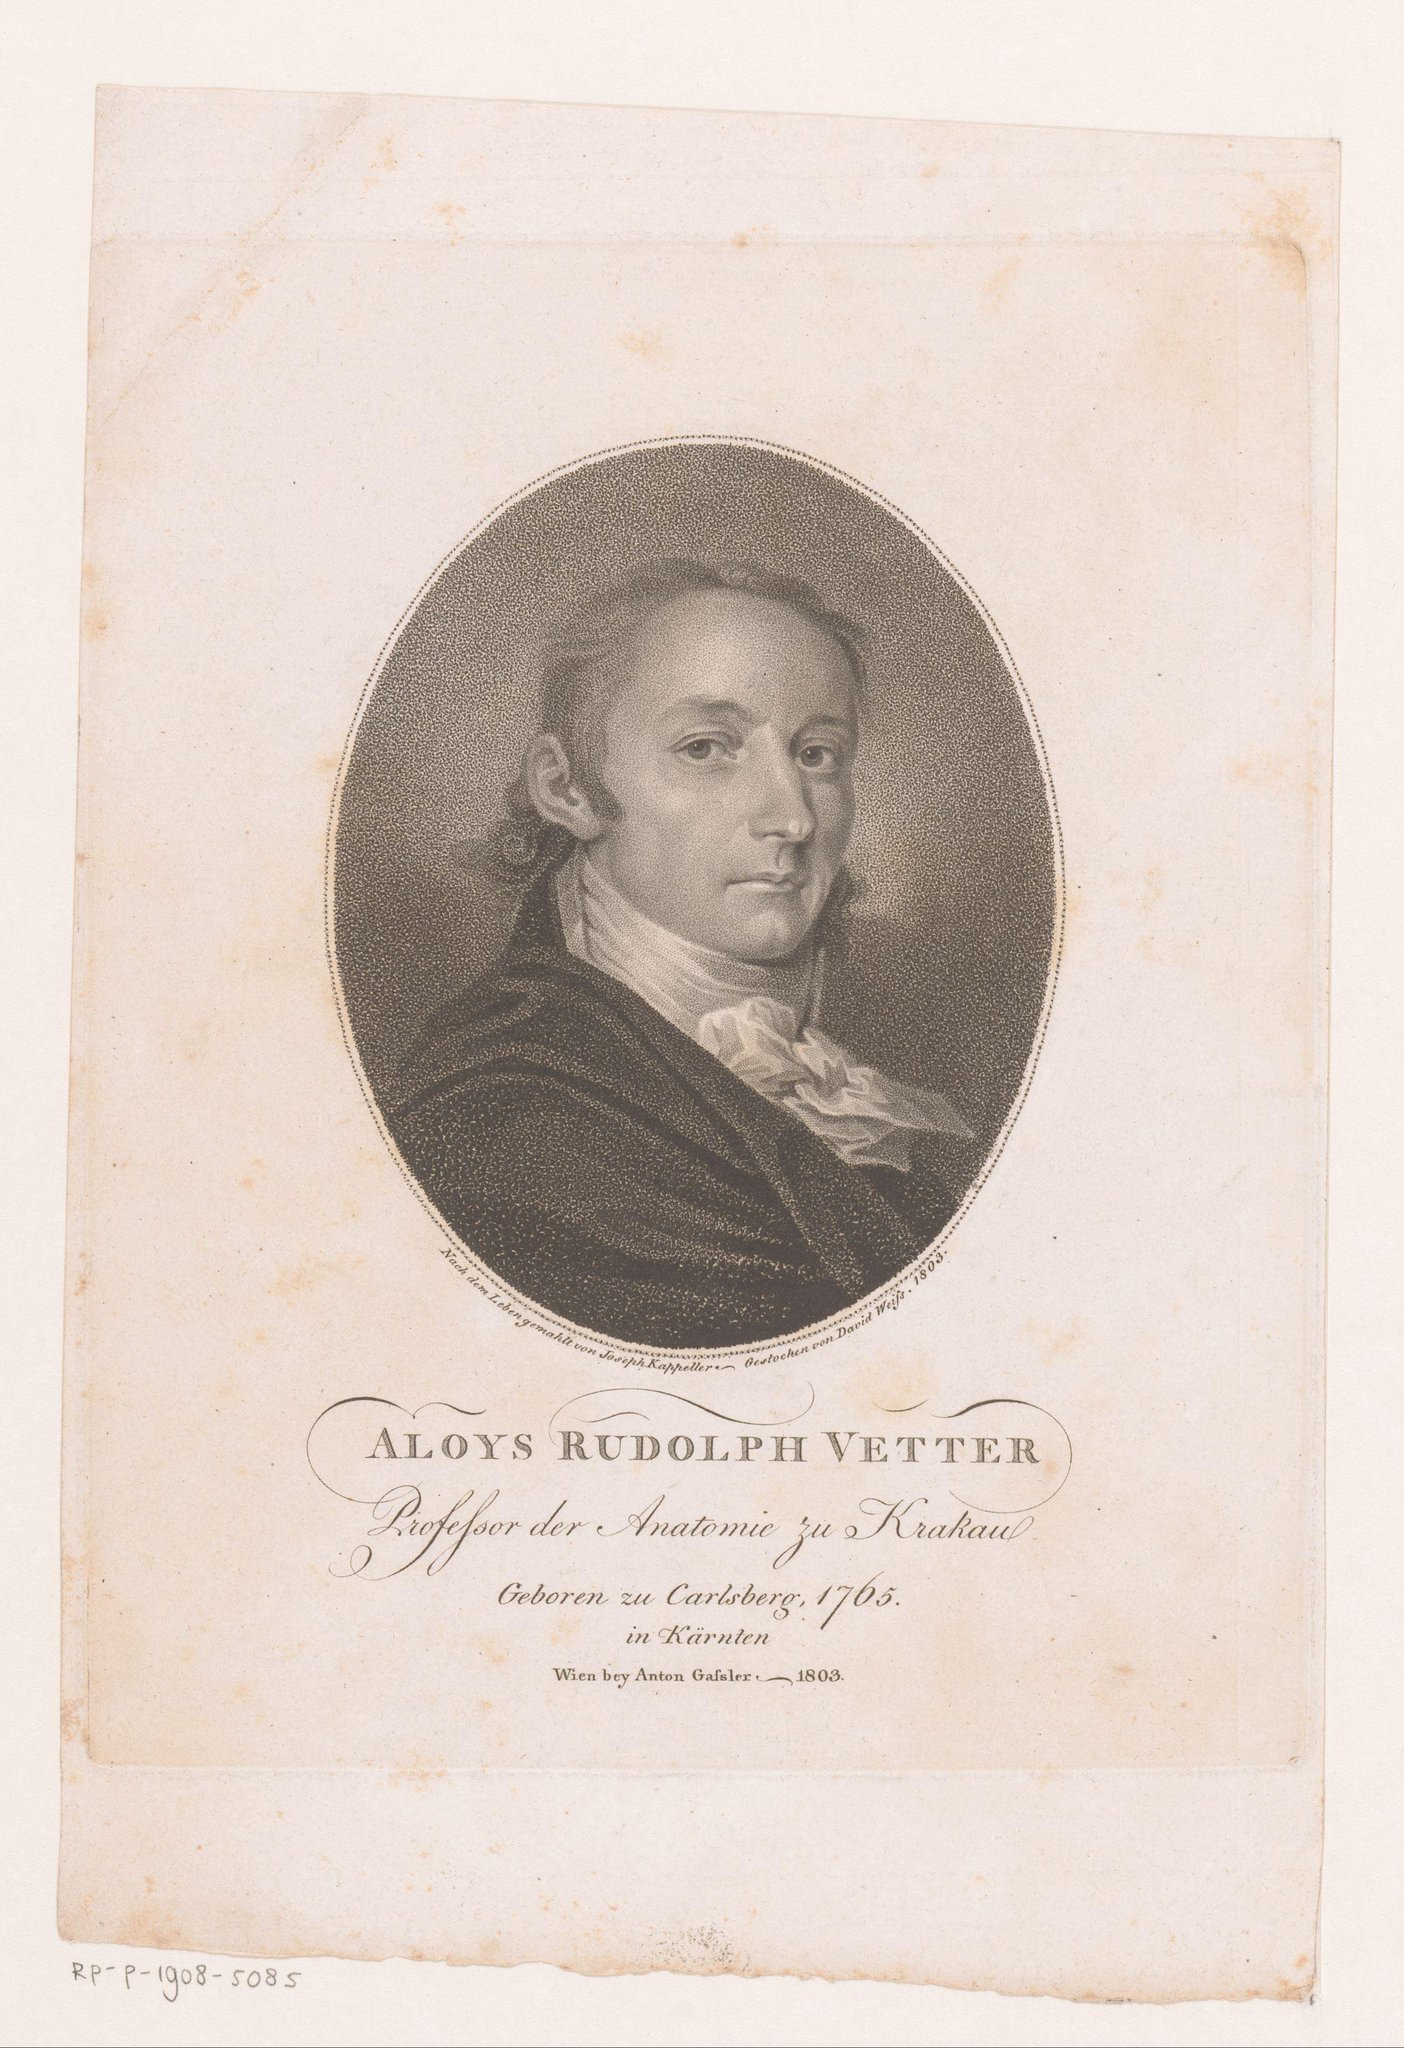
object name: print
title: Portret van Alois Rudolf Vetter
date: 1803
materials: paper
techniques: engraving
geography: vienna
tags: vienna, historical persons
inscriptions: collector's mark: Lugt 2228